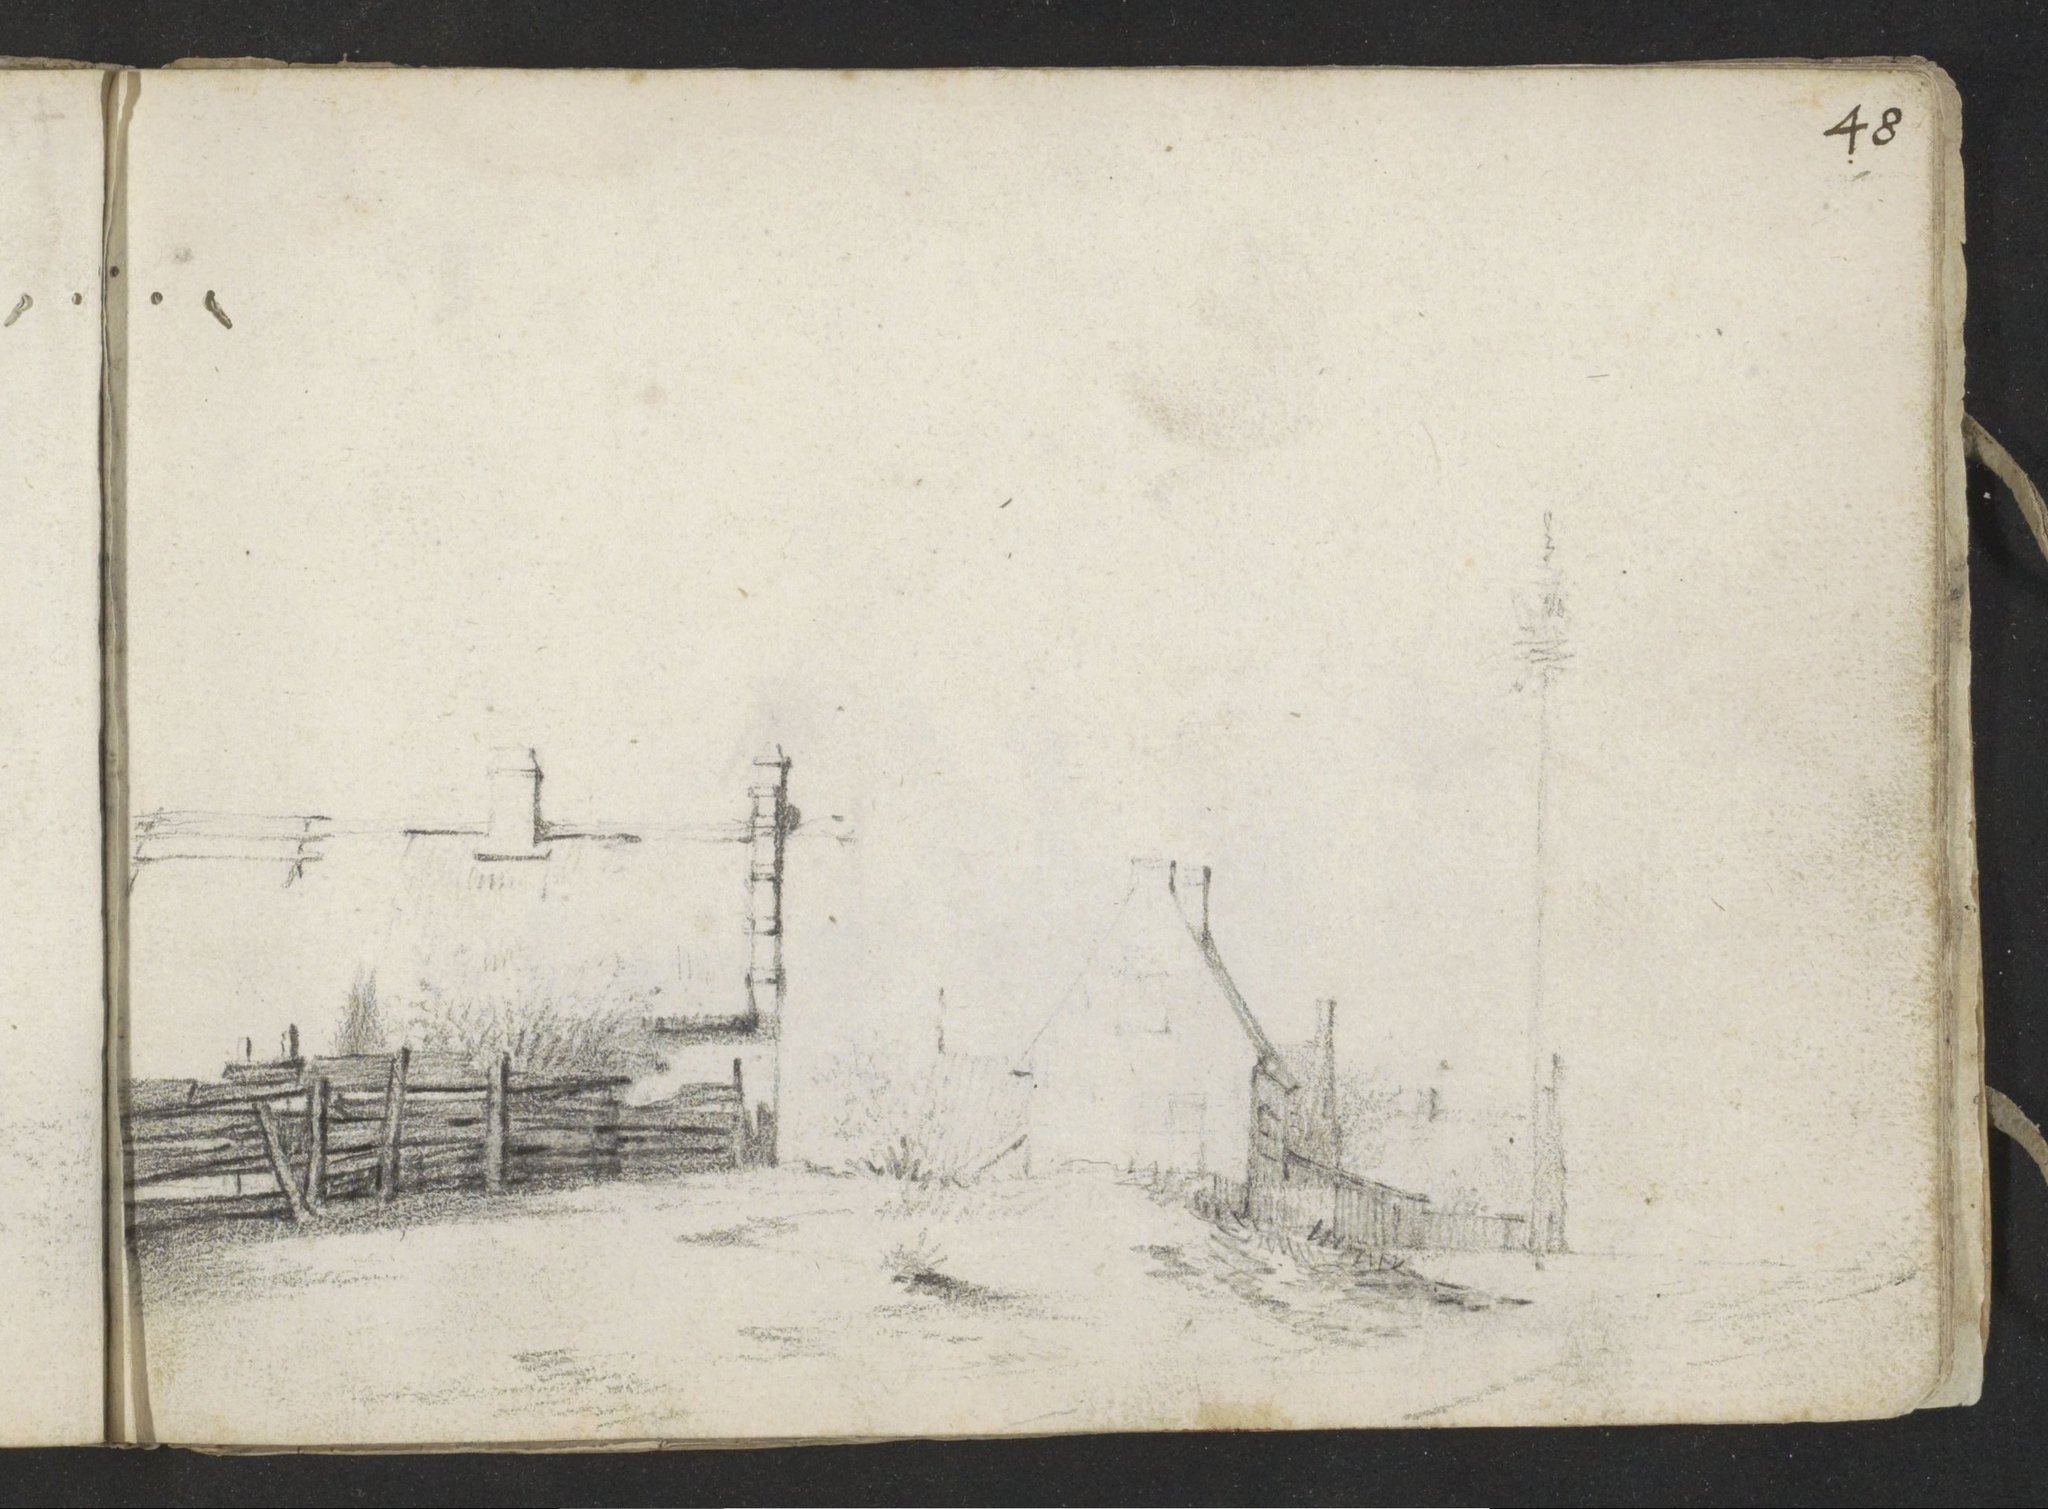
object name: sketchbook leaf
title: Huizen langs een duinpad buiten Haarlem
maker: gerard ter borch (ii)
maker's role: draughtsman, painter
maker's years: 1617-1681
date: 1634-1635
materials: chalk, paper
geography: haarlem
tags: city-view, and landscape with man-made constructions, fence, wall, paling, haarlem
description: Blad 48 recto uit een schetsboek met 55 bladen.